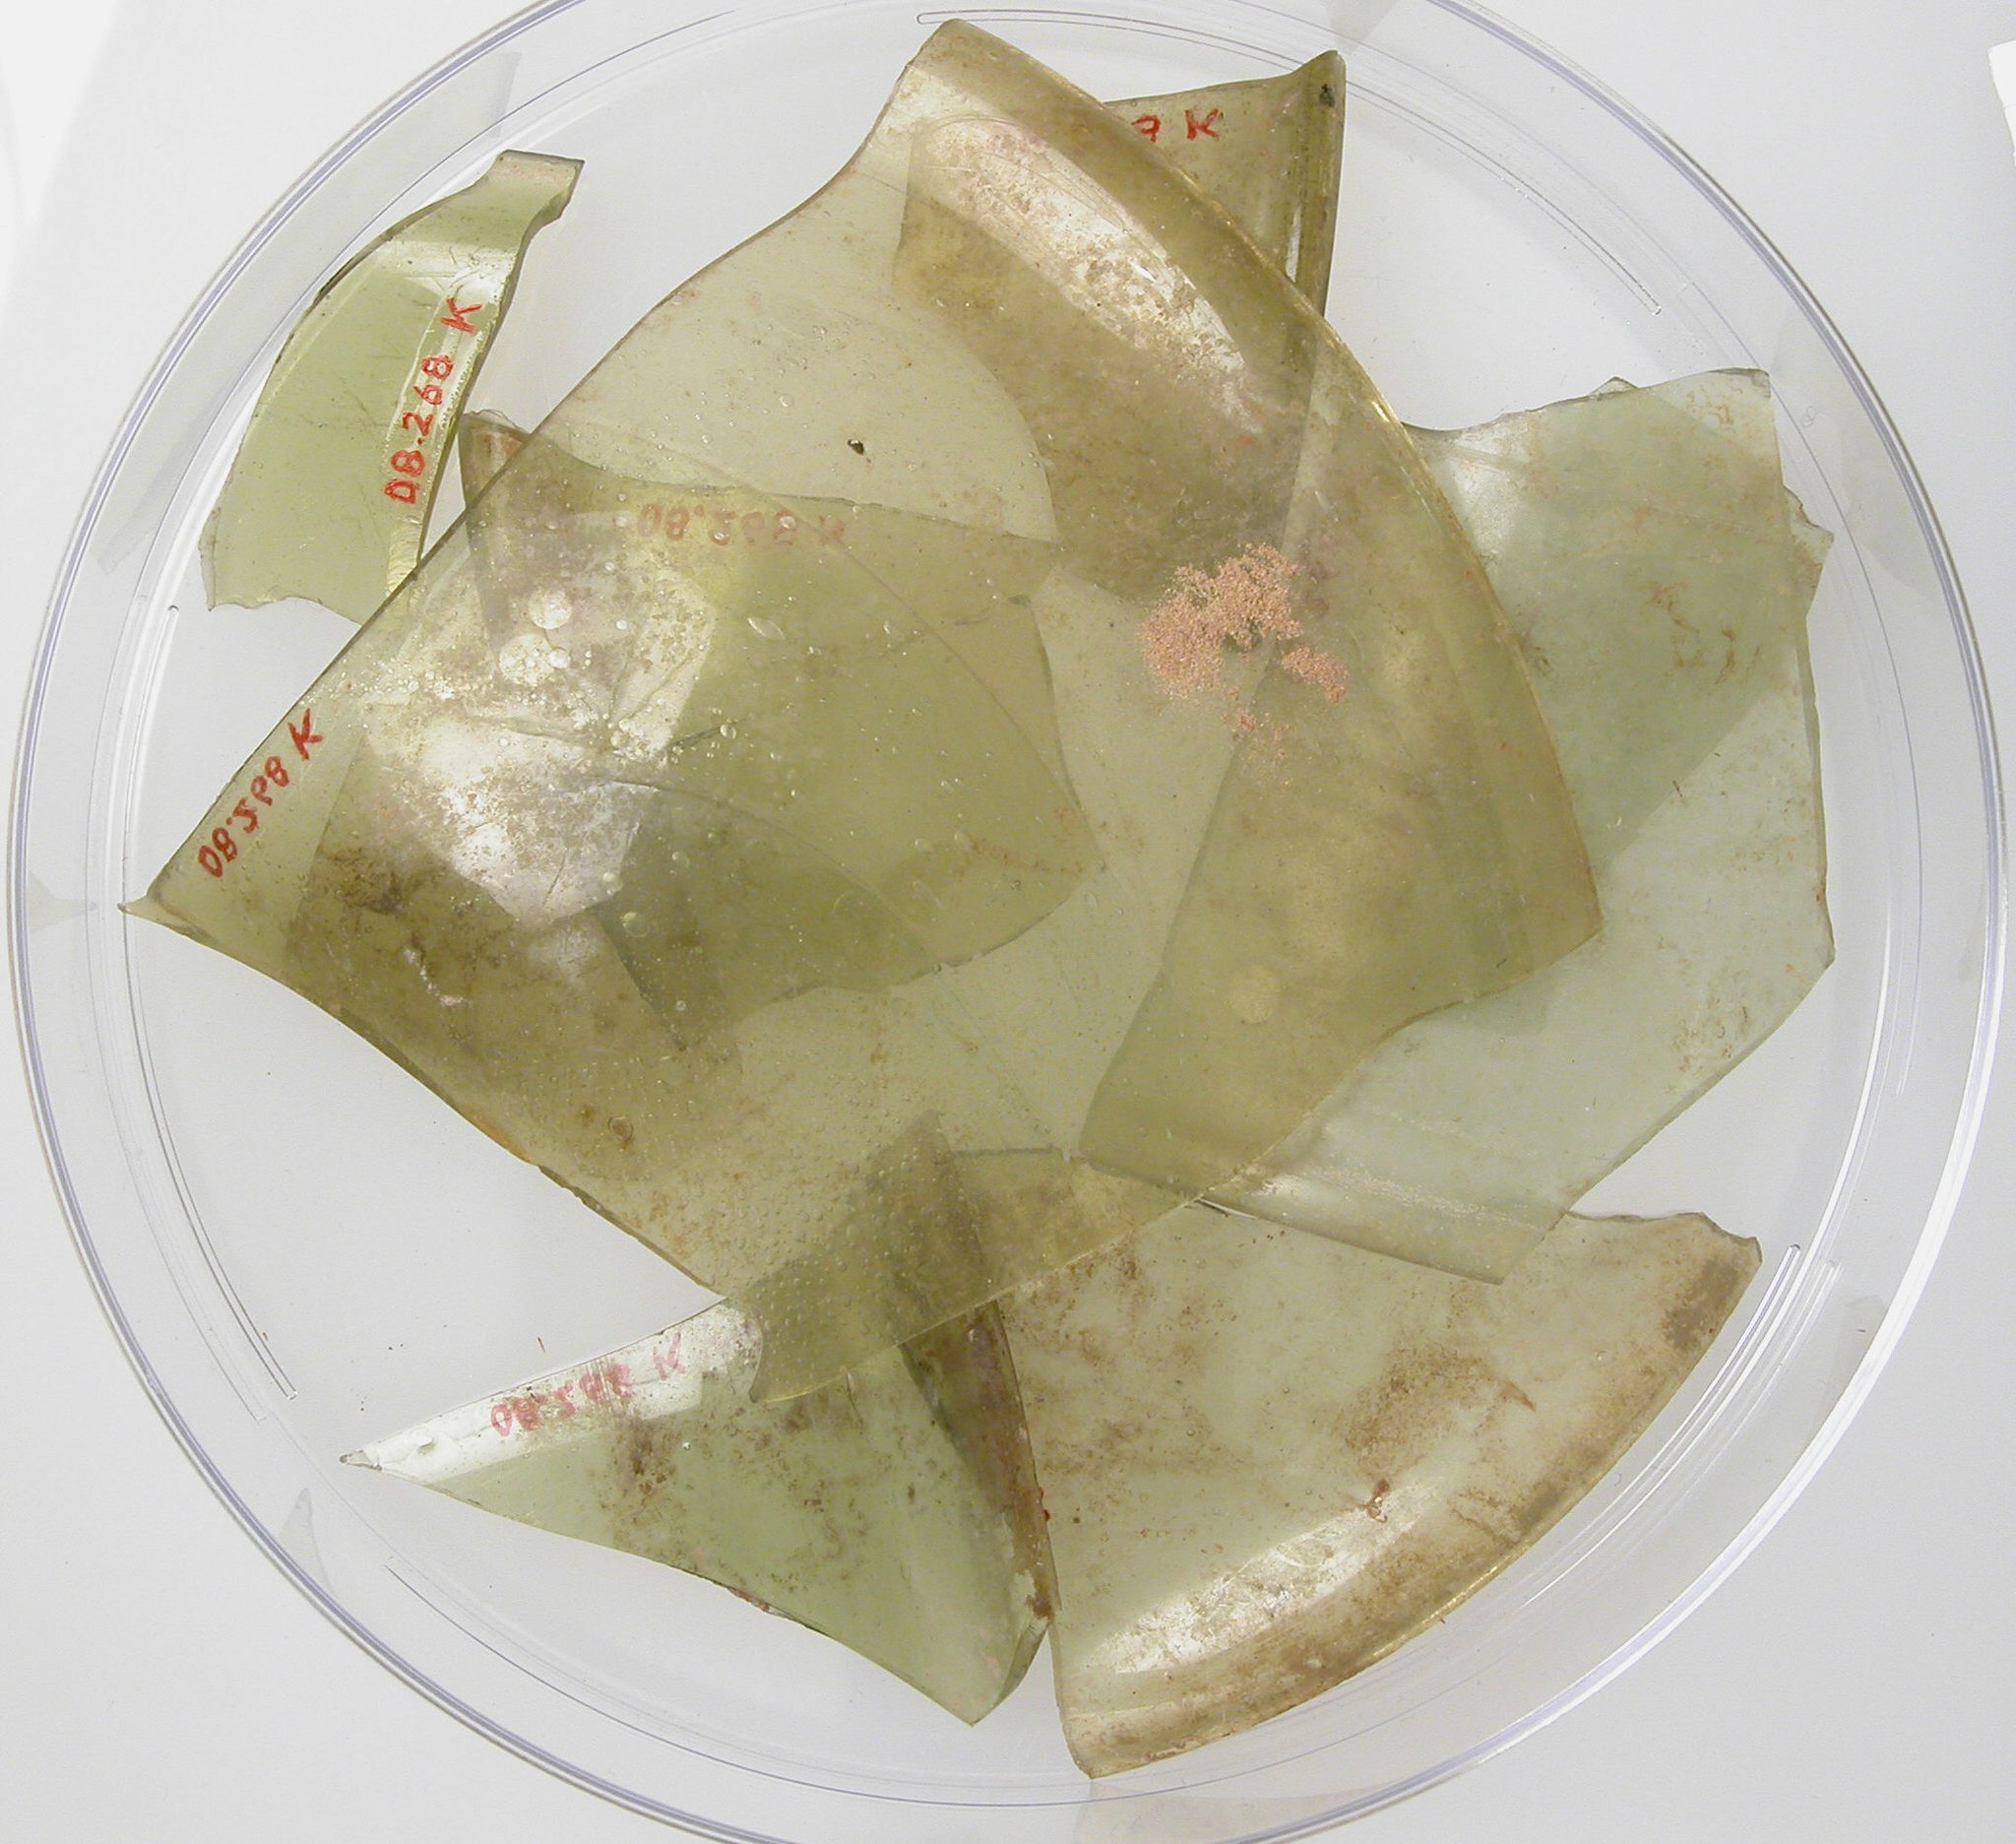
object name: fragment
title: Glass Fragments from a Vessel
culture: coptic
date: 301-433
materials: glass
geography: egypt